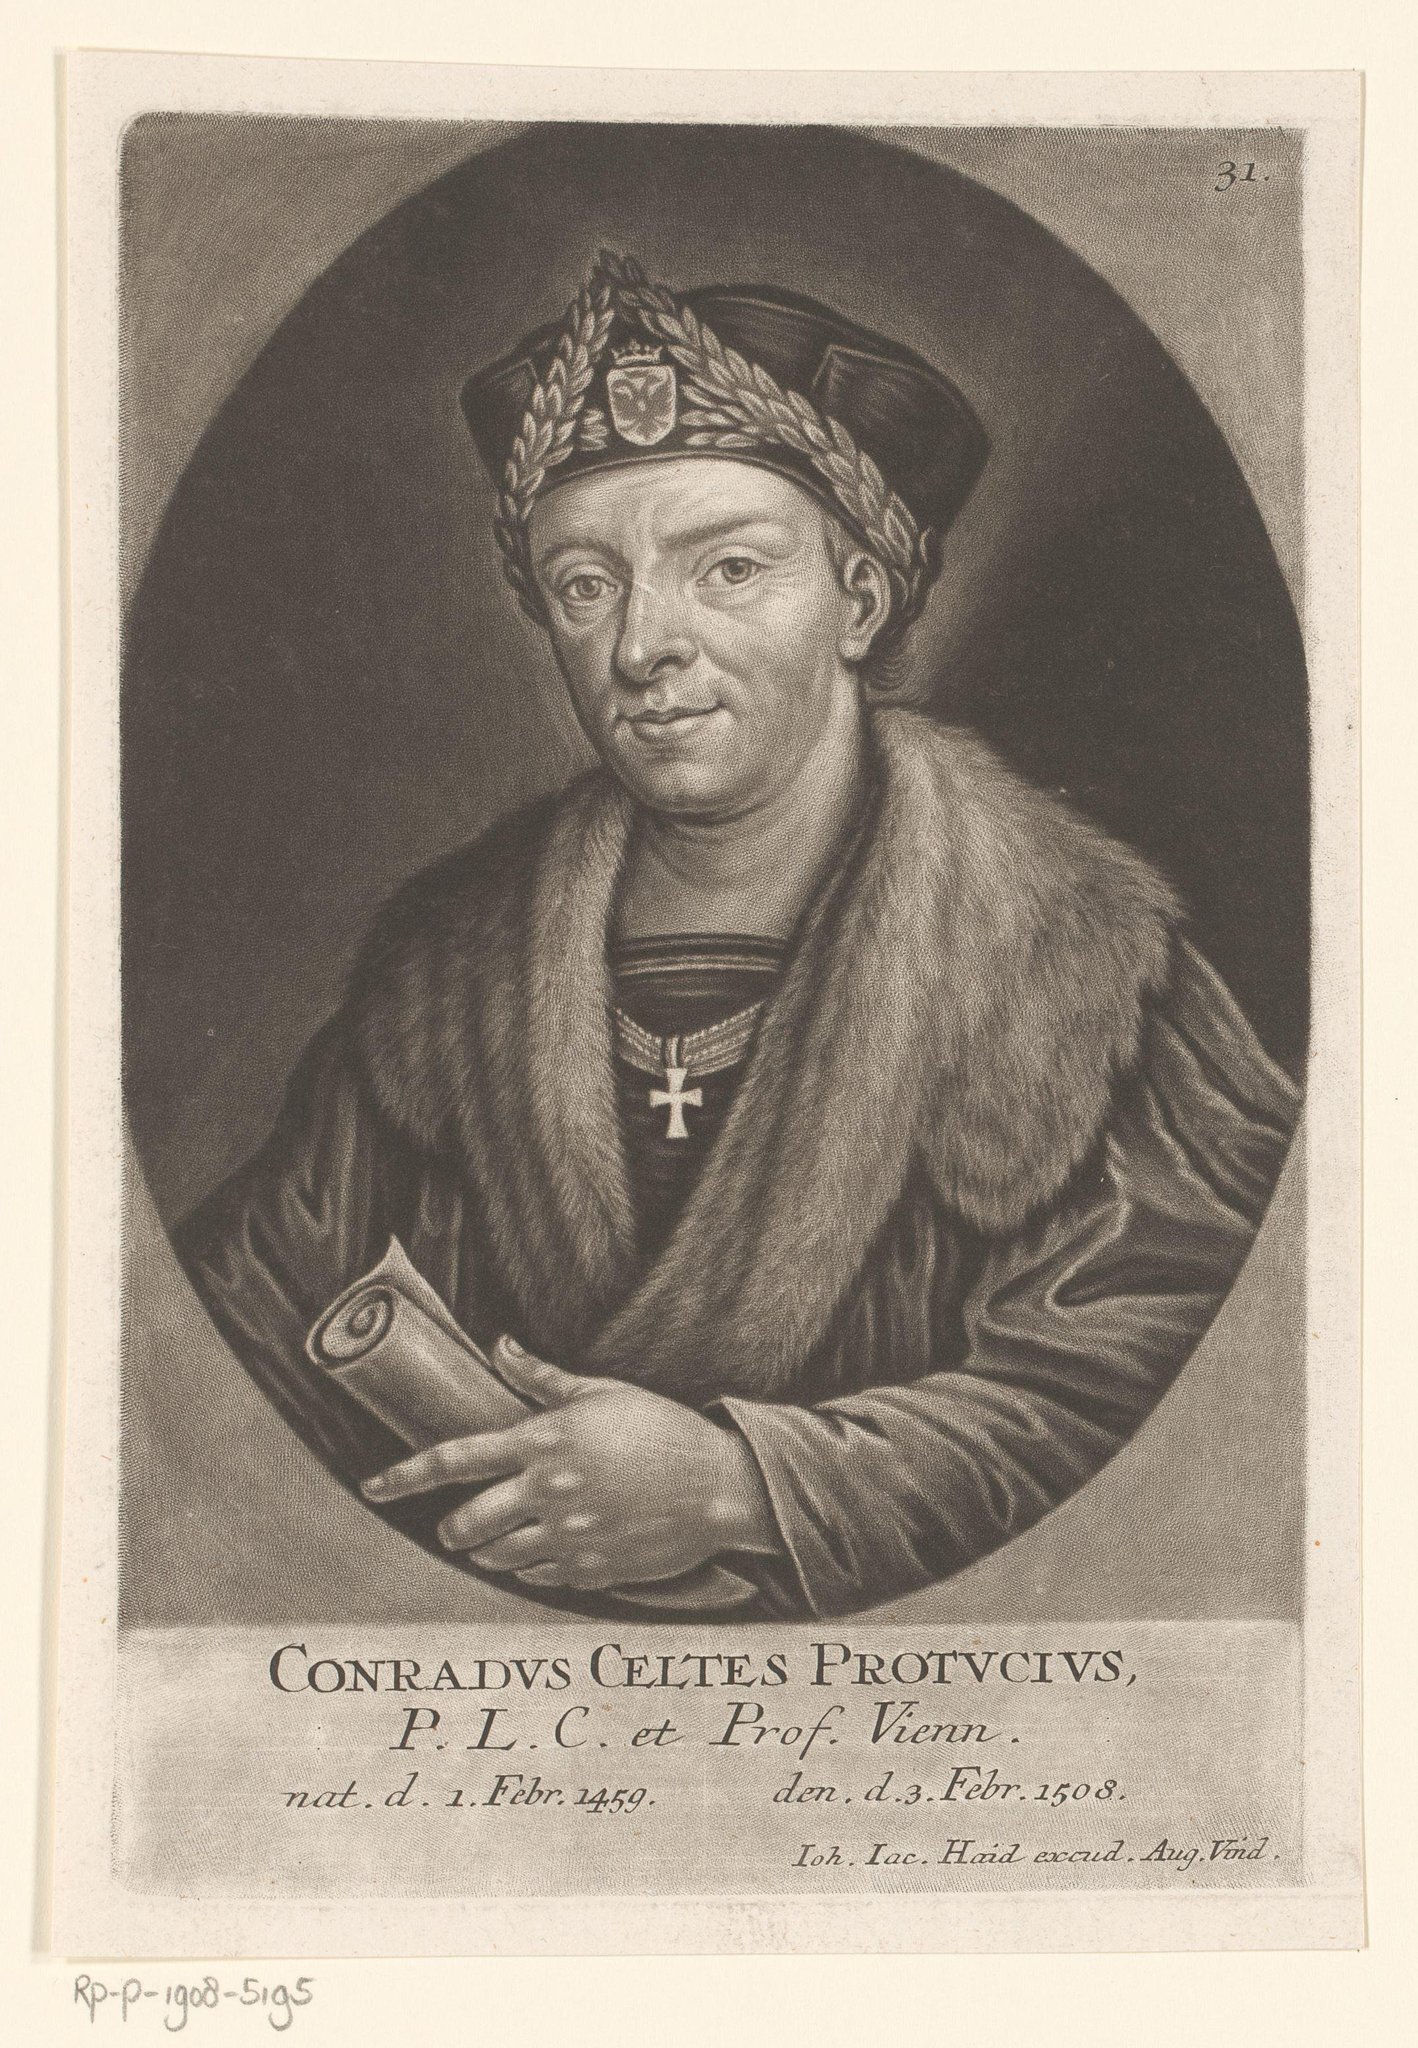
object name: print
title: Portret van Conrad Celtis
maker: johann jacob haid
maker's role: print maker, publisher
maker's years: 1704-1767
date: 1747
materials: paper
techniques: mezzotint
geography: augsburg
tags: historical persons, writer, poet, author, scroll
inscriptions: collector's mark: Lugt 2228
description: Prent gebruikt voor: Brucker, Jacob. Ehrentempel der Deutschen Gelehrsamkeit. Augsburg: Johann Jacob Haid, 1747.